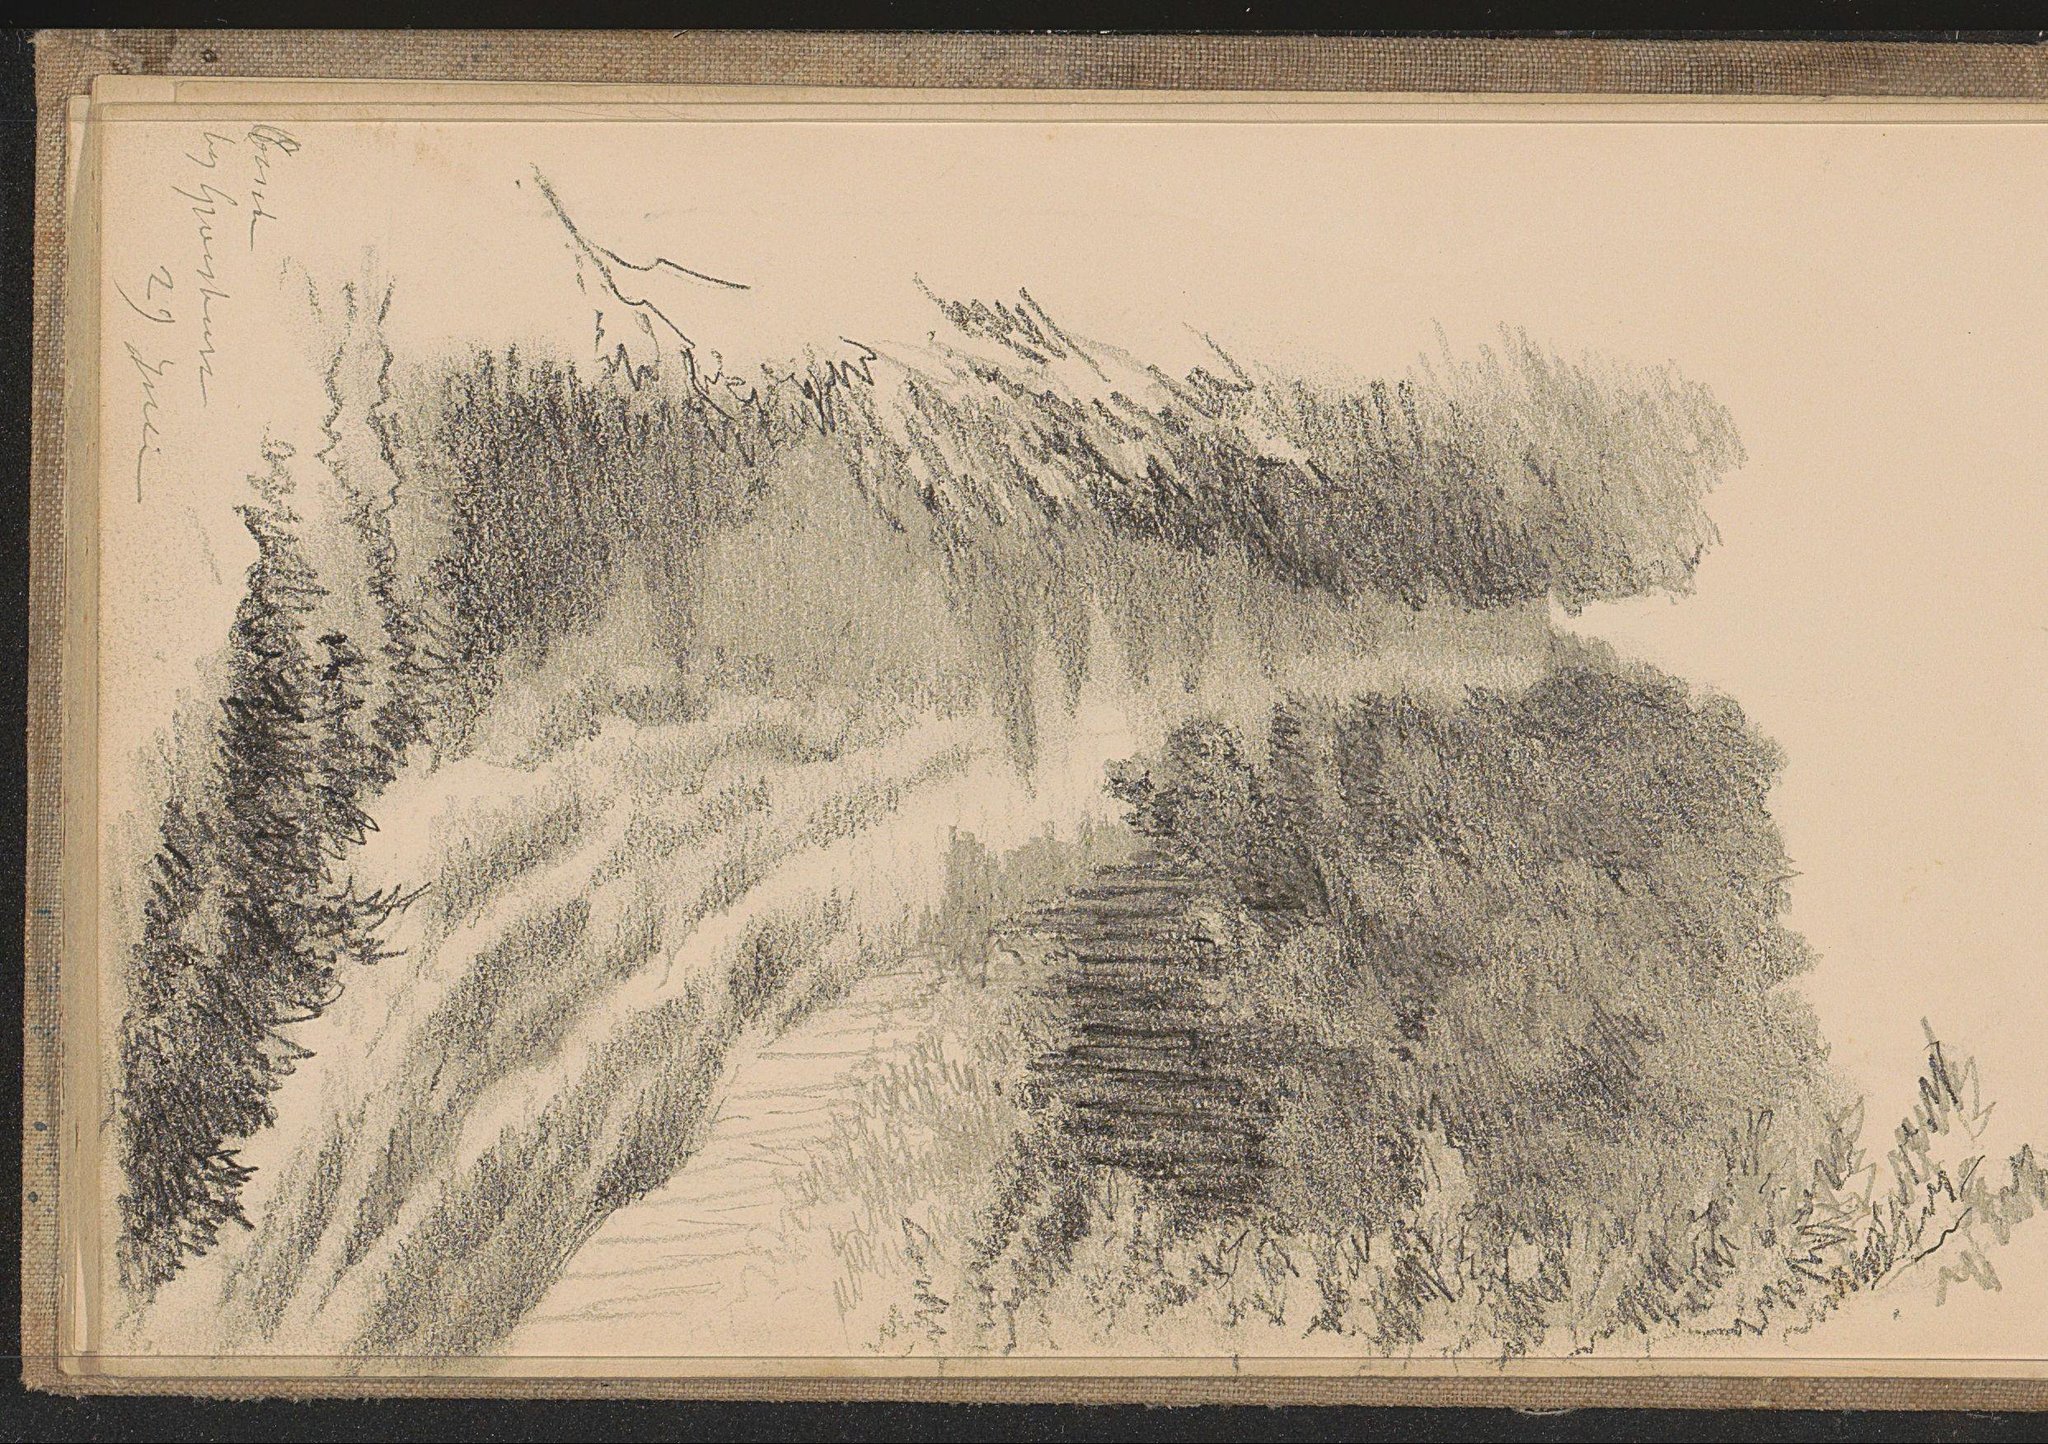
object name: sketchbook leaf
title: Bospad bij Groesbeek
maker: anna catharina maria van eeghen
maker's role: draughtsman, print maker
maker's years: 1878-1924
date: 1901-1907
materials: paper, pencil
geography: groesbeek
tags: forest, wood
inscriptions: date and inscription: ‘Bosch/ bij Groesbeek/ 29 Juli’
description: Blad 11 verso uit een schetsboek met 33 bladen.